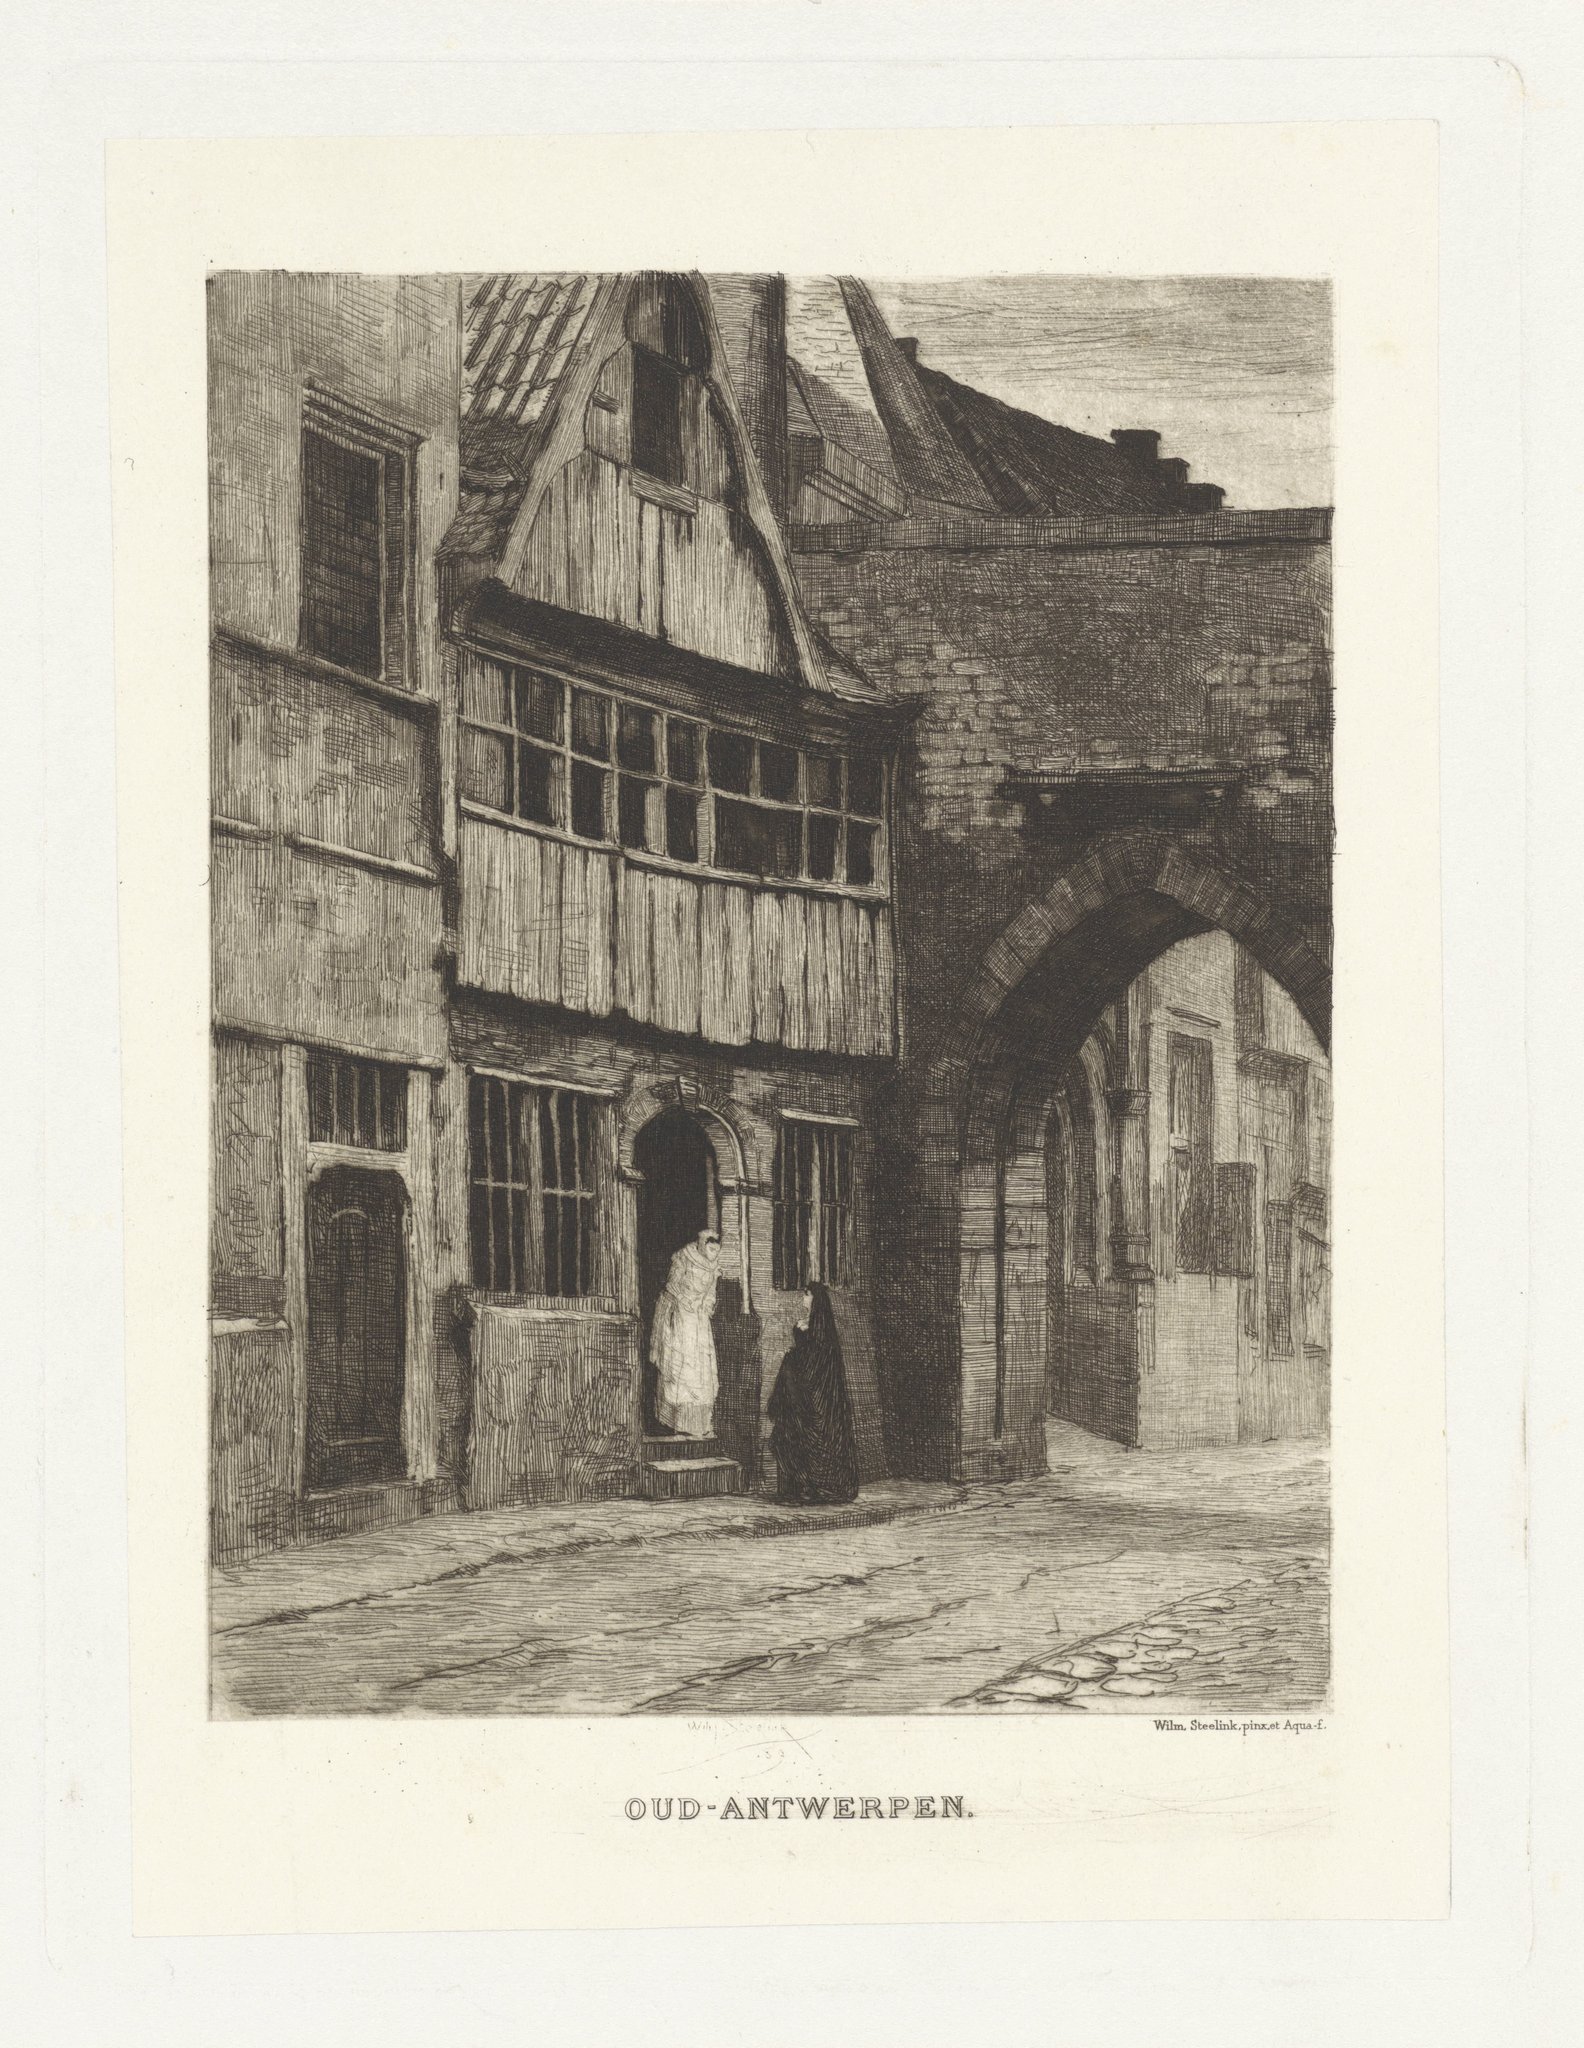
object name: print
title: Oud-Antwerpen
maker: willem steelink (ii)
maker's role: draughtsman, print maker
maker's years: 1856-1928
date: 1889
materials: paper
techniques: etching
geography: netherlands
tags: open door, gate, entrance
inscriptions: collector's mark: Lugt 2228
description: Een non spreekt met een vrouw, die in de deuropening van een huis staat. Rechts een poort.